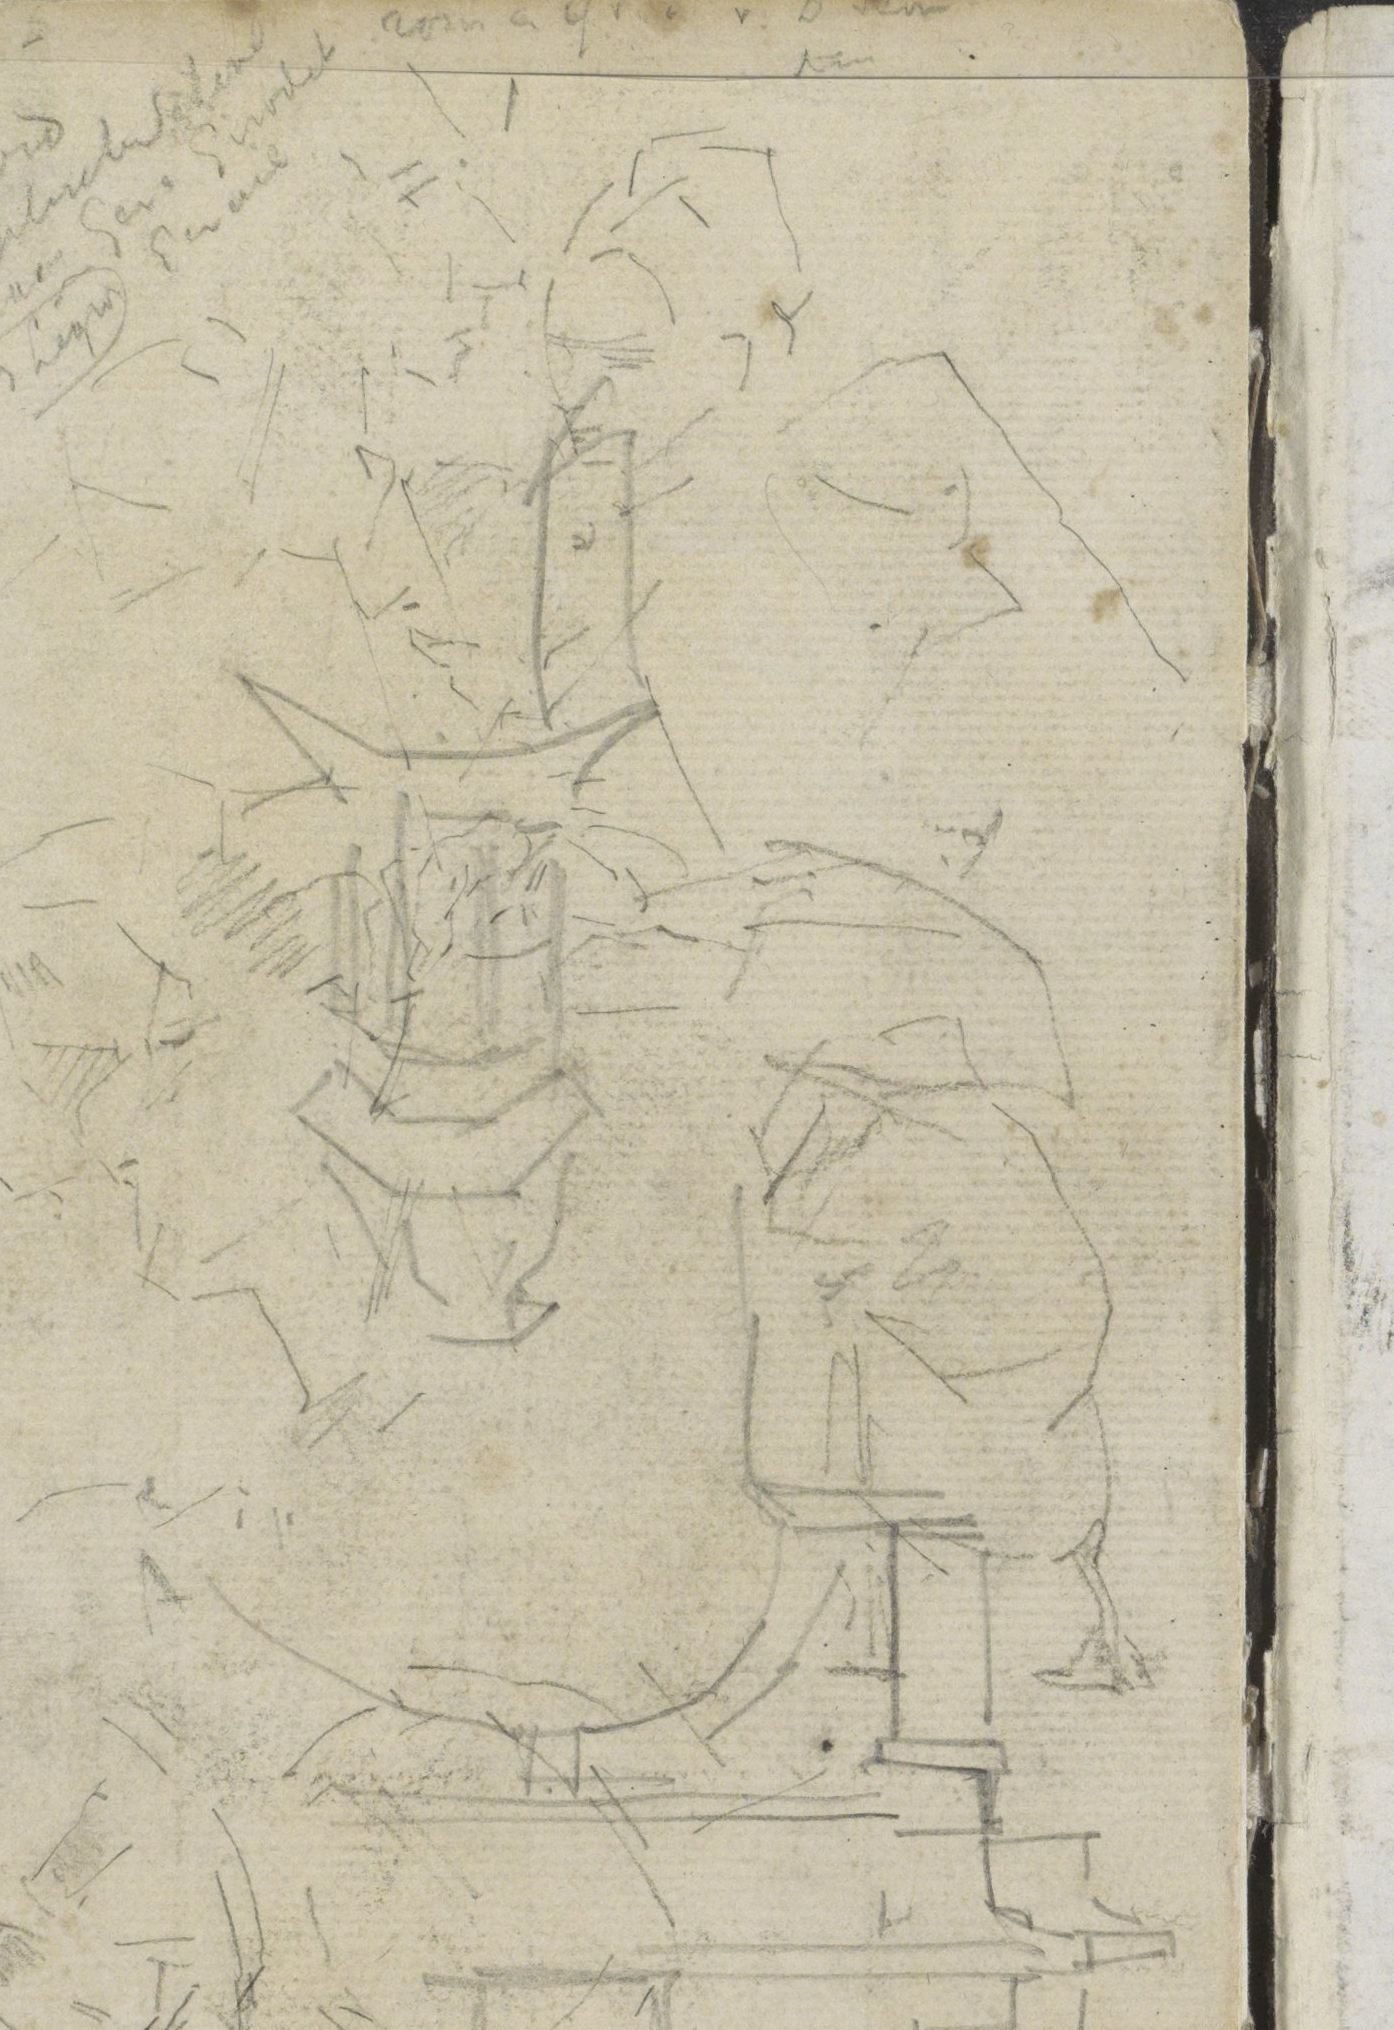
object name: sketchbook leaf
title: Architectuurstudies en figuurstudies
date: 1880-1882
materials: chalk, paper, pencil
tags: adult woman, architectural detail, adult man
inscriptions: collector's mark: Lugt 2228, annotation: ‘[...]’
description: Blad 30 verso uit een schetsboek met 10 bladen.